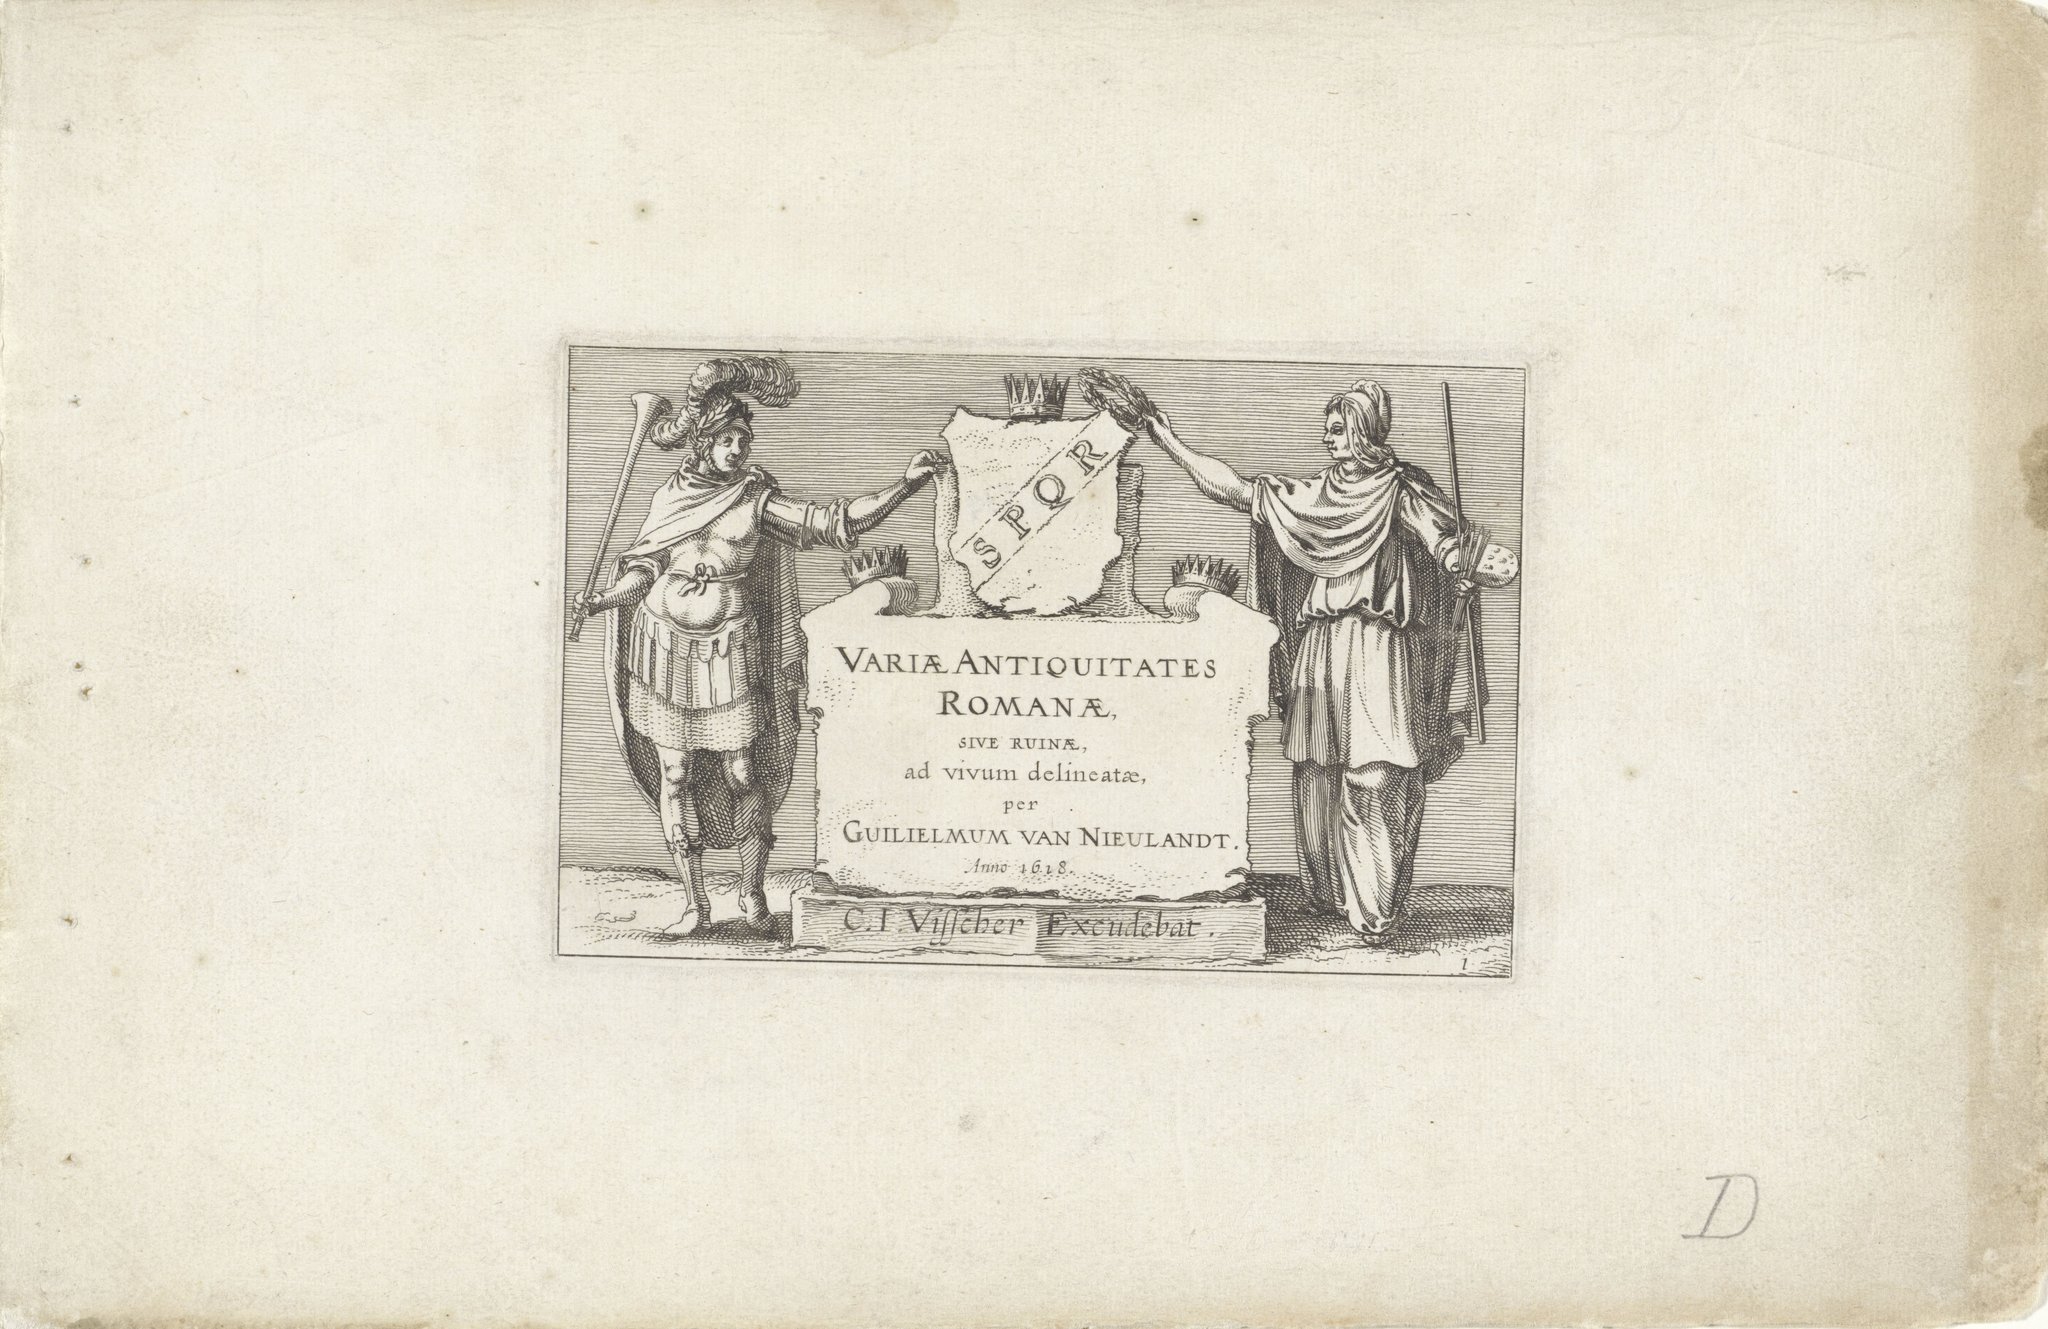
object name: titelprent, frontispice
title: Titelprent met een soldaat en een vrouw met schildersattributen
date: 1618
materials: paper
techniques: etching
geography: amsterdam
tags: crown (symbol of sovereignty), trees: laurel, tools, implements of painter, the soldier; the soldier's life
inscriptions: address: ‘C.I.Visscher Excudebat’, collector's mark: 2233, number: ‘1’, title: ‘Variae antiquitates Romanae’, signature and date: ‘ad vivum / delineatae / per / Guilielmum van Nieulandt. Anno 1618’ Lugt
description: Titelprent voor een serie van 24 Italiaanse landschappen met ruïnes. De titel staat op een steen, waarboven het wapen van Rome. De titel wordt geflankeerd door een soldaat en een vrouw met schildersattributen.